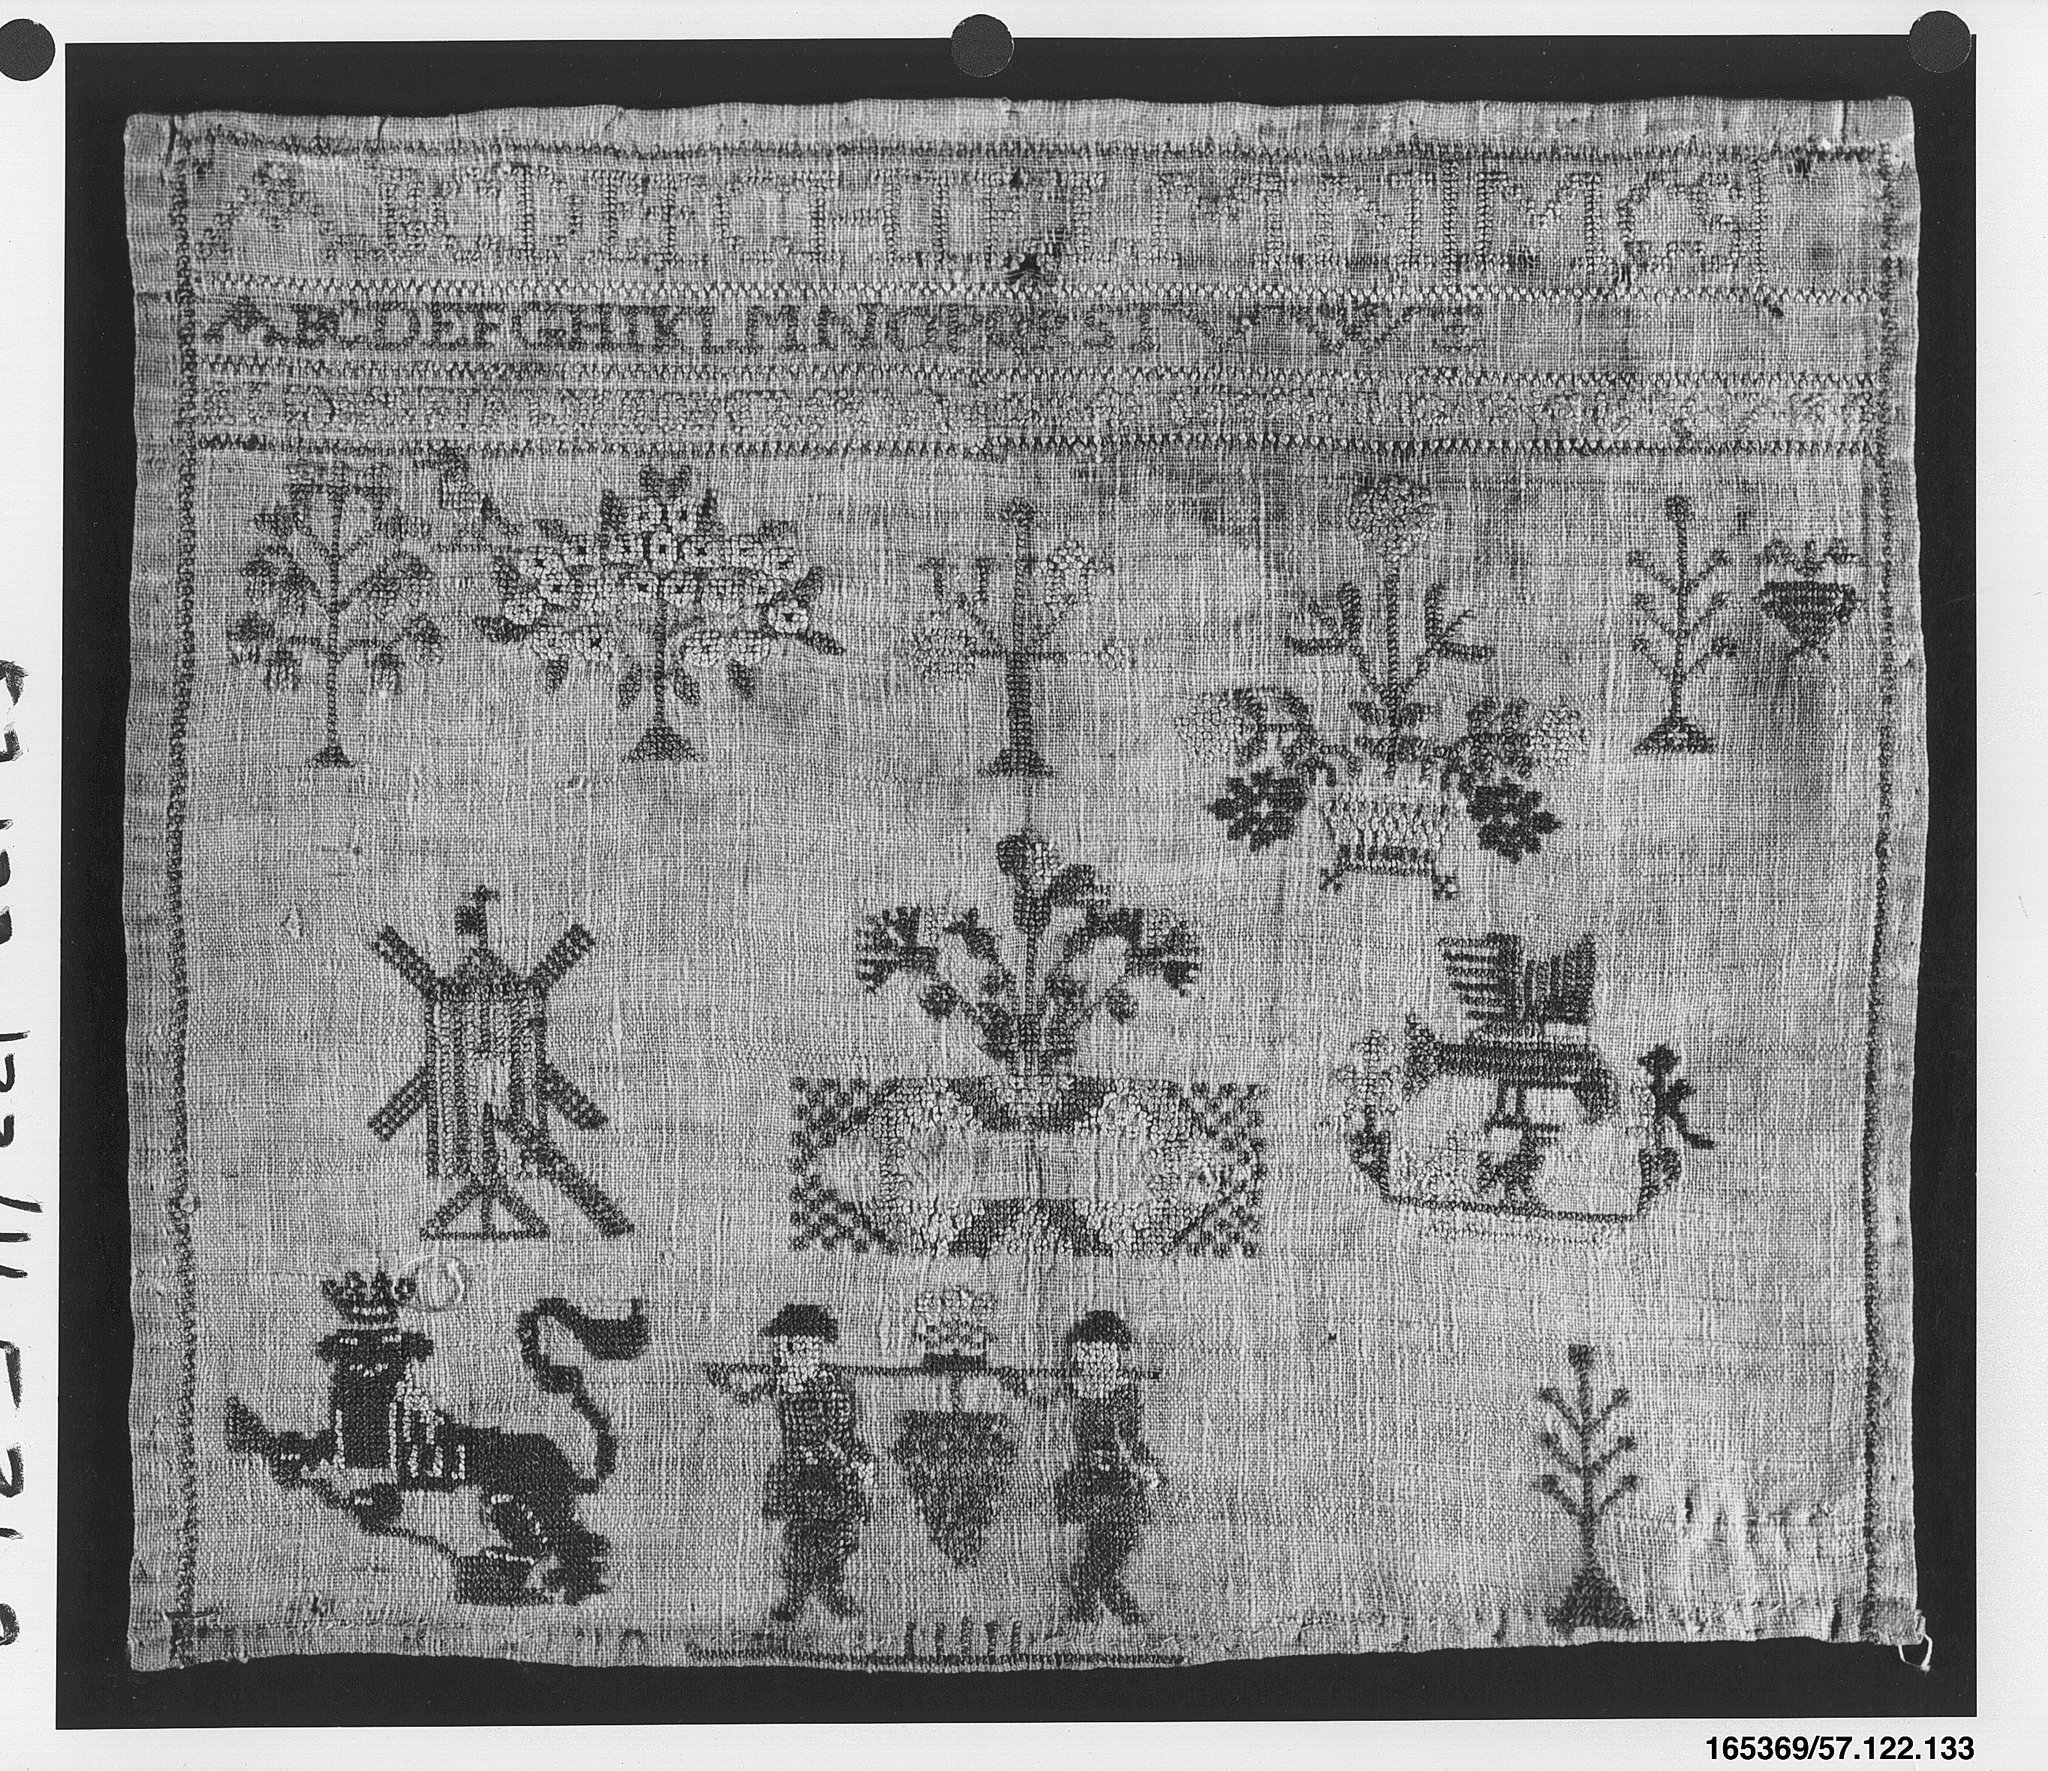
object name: sampler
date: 1701-1800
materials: linen, silk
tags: animals,trees